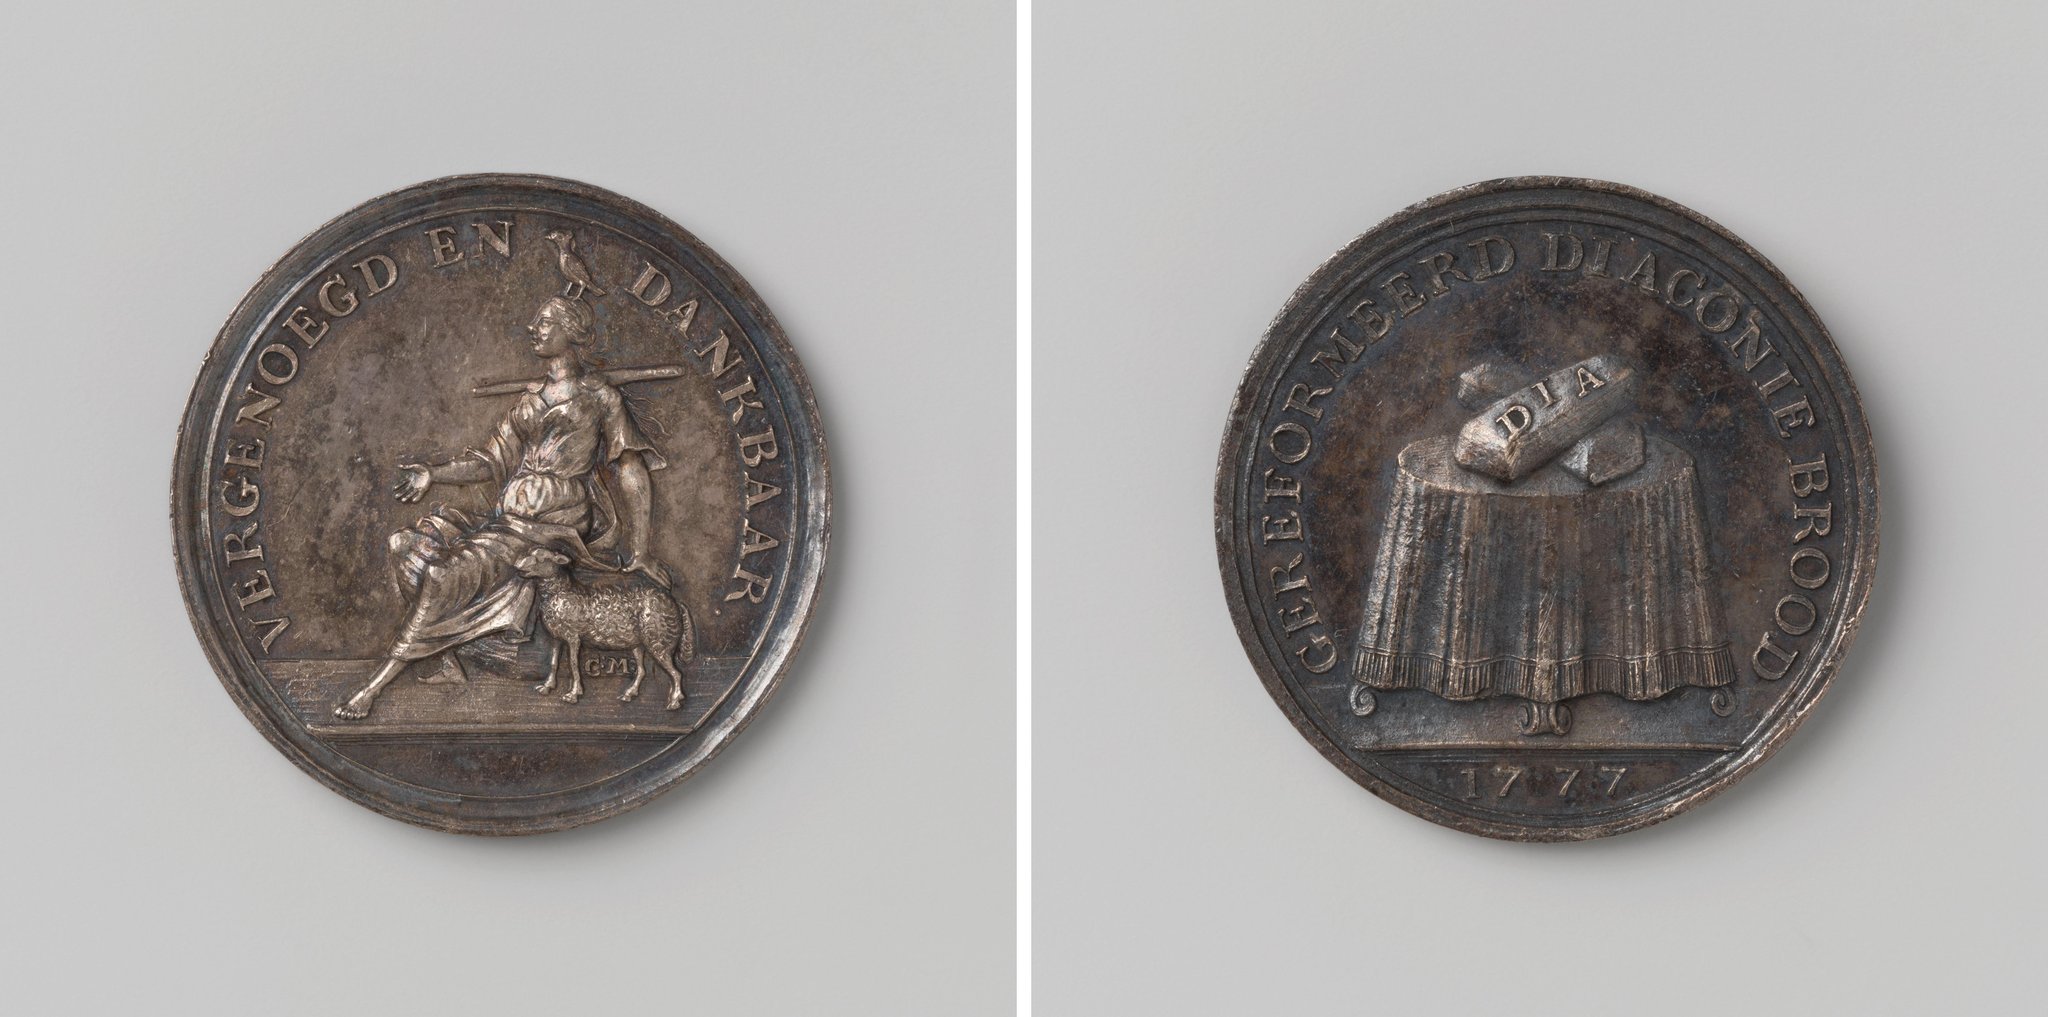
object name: broodpenning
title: Gereformeerde Diakonie te Amsterdam, penning in de vorm van een armenpenning, geschonken aan nieuw aangekomen diakenen en diakenessen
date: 1777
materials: silver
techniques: striking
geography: amsterdam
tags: amsterdam